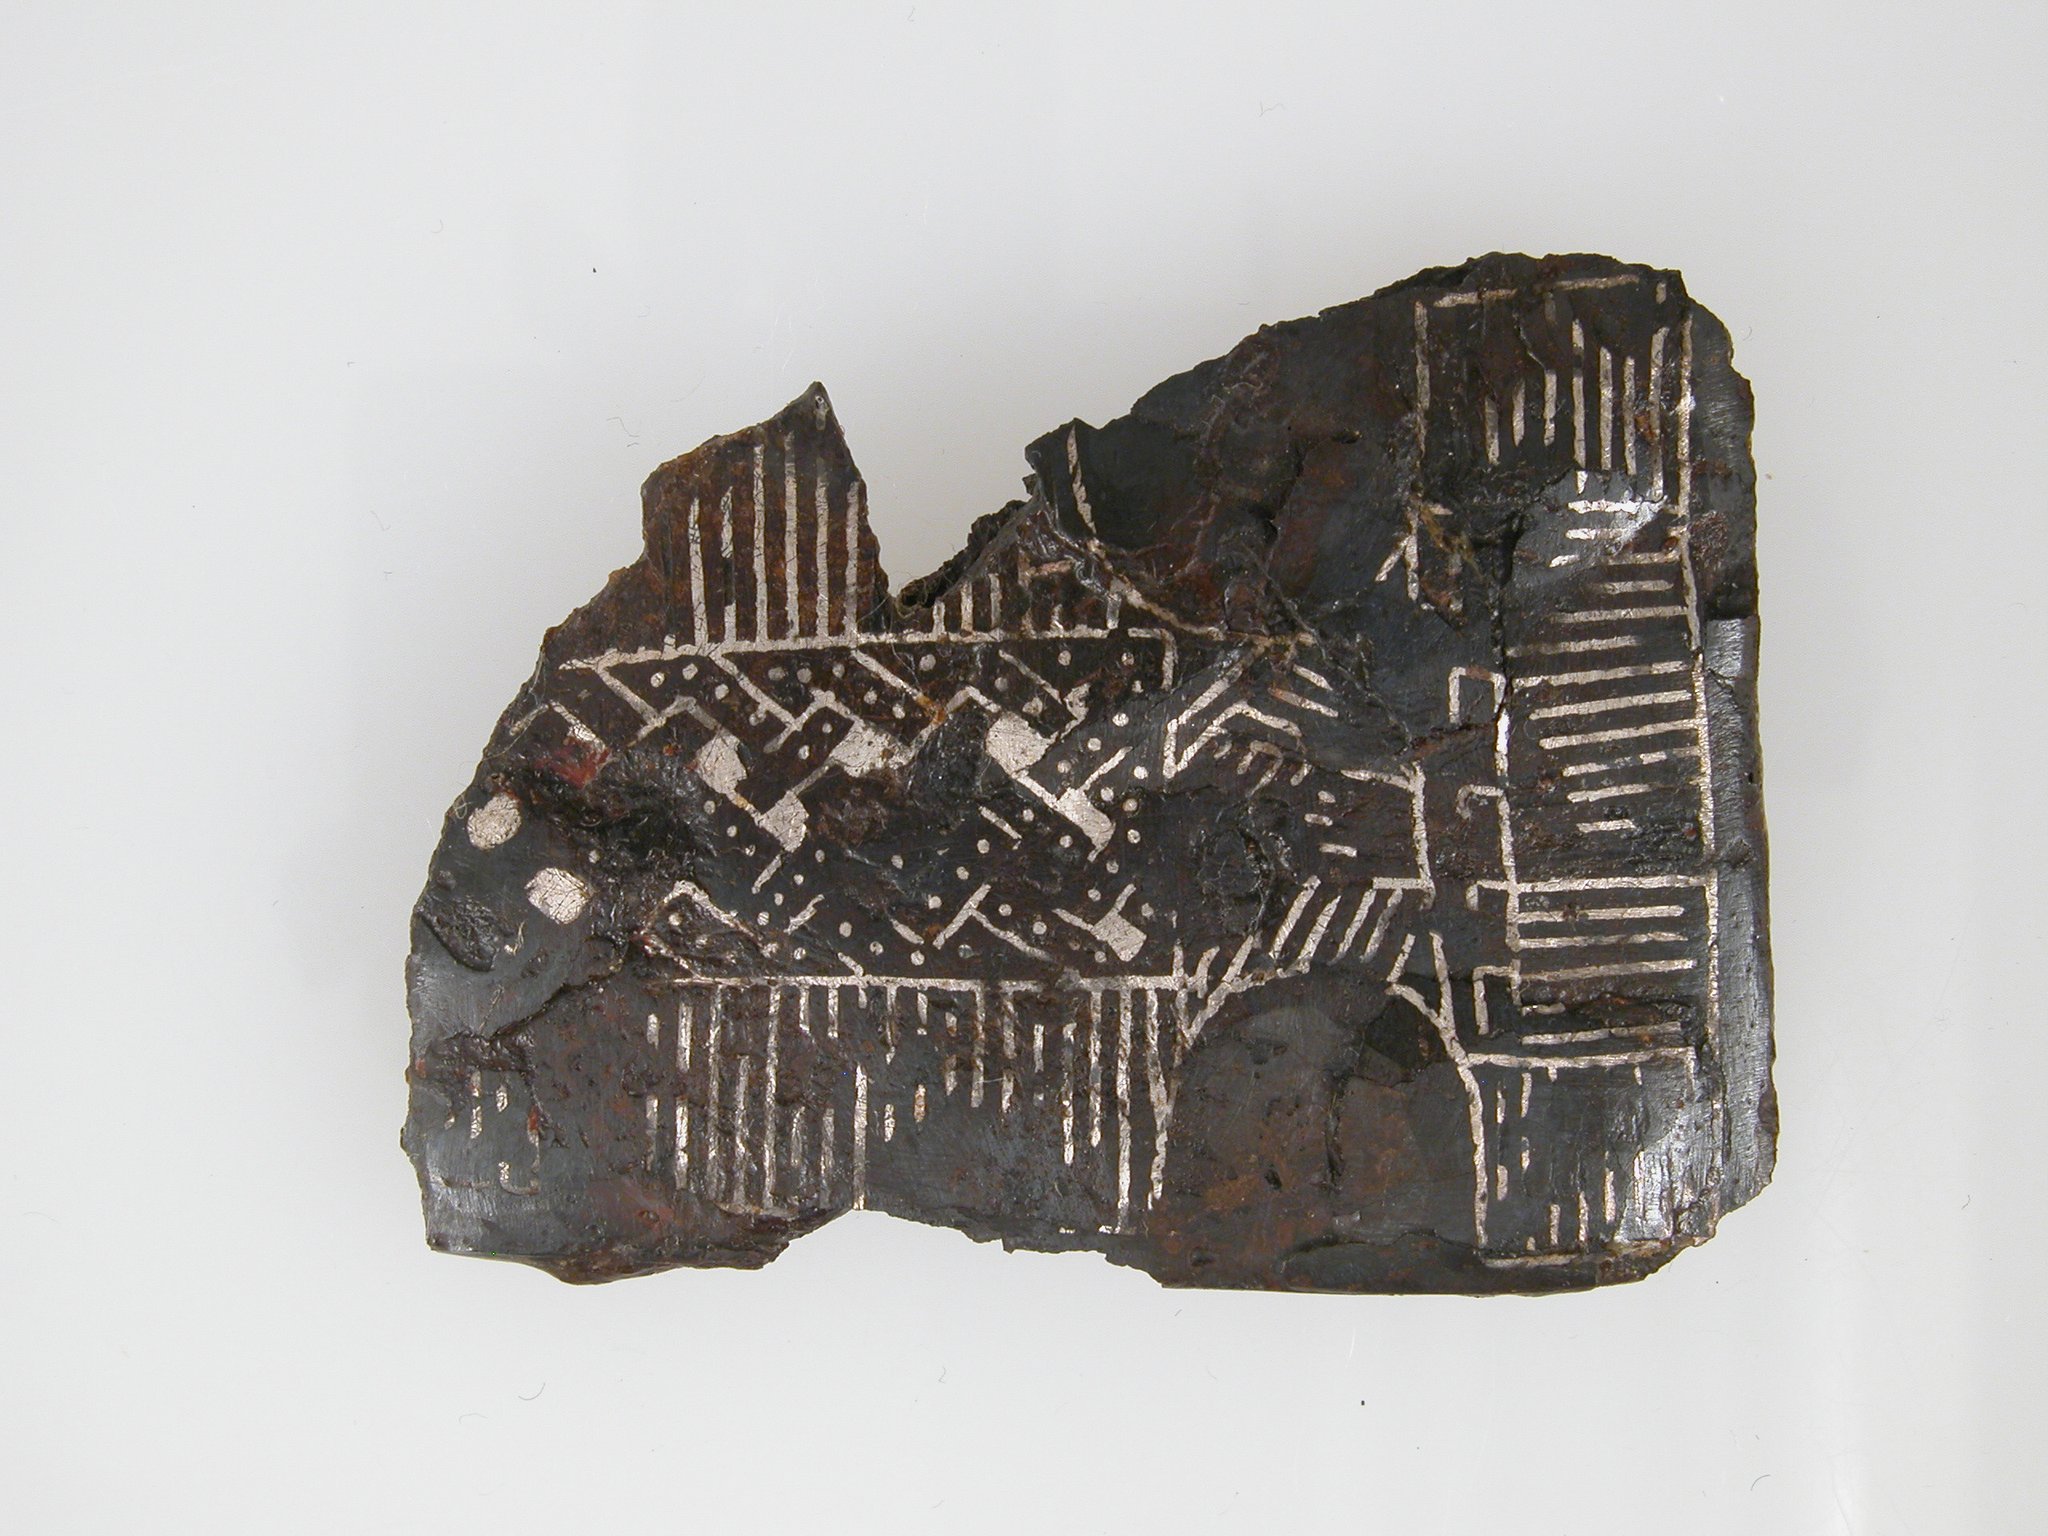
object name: belt plate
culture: frankish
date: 301-700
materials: iron, silver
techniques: inlay